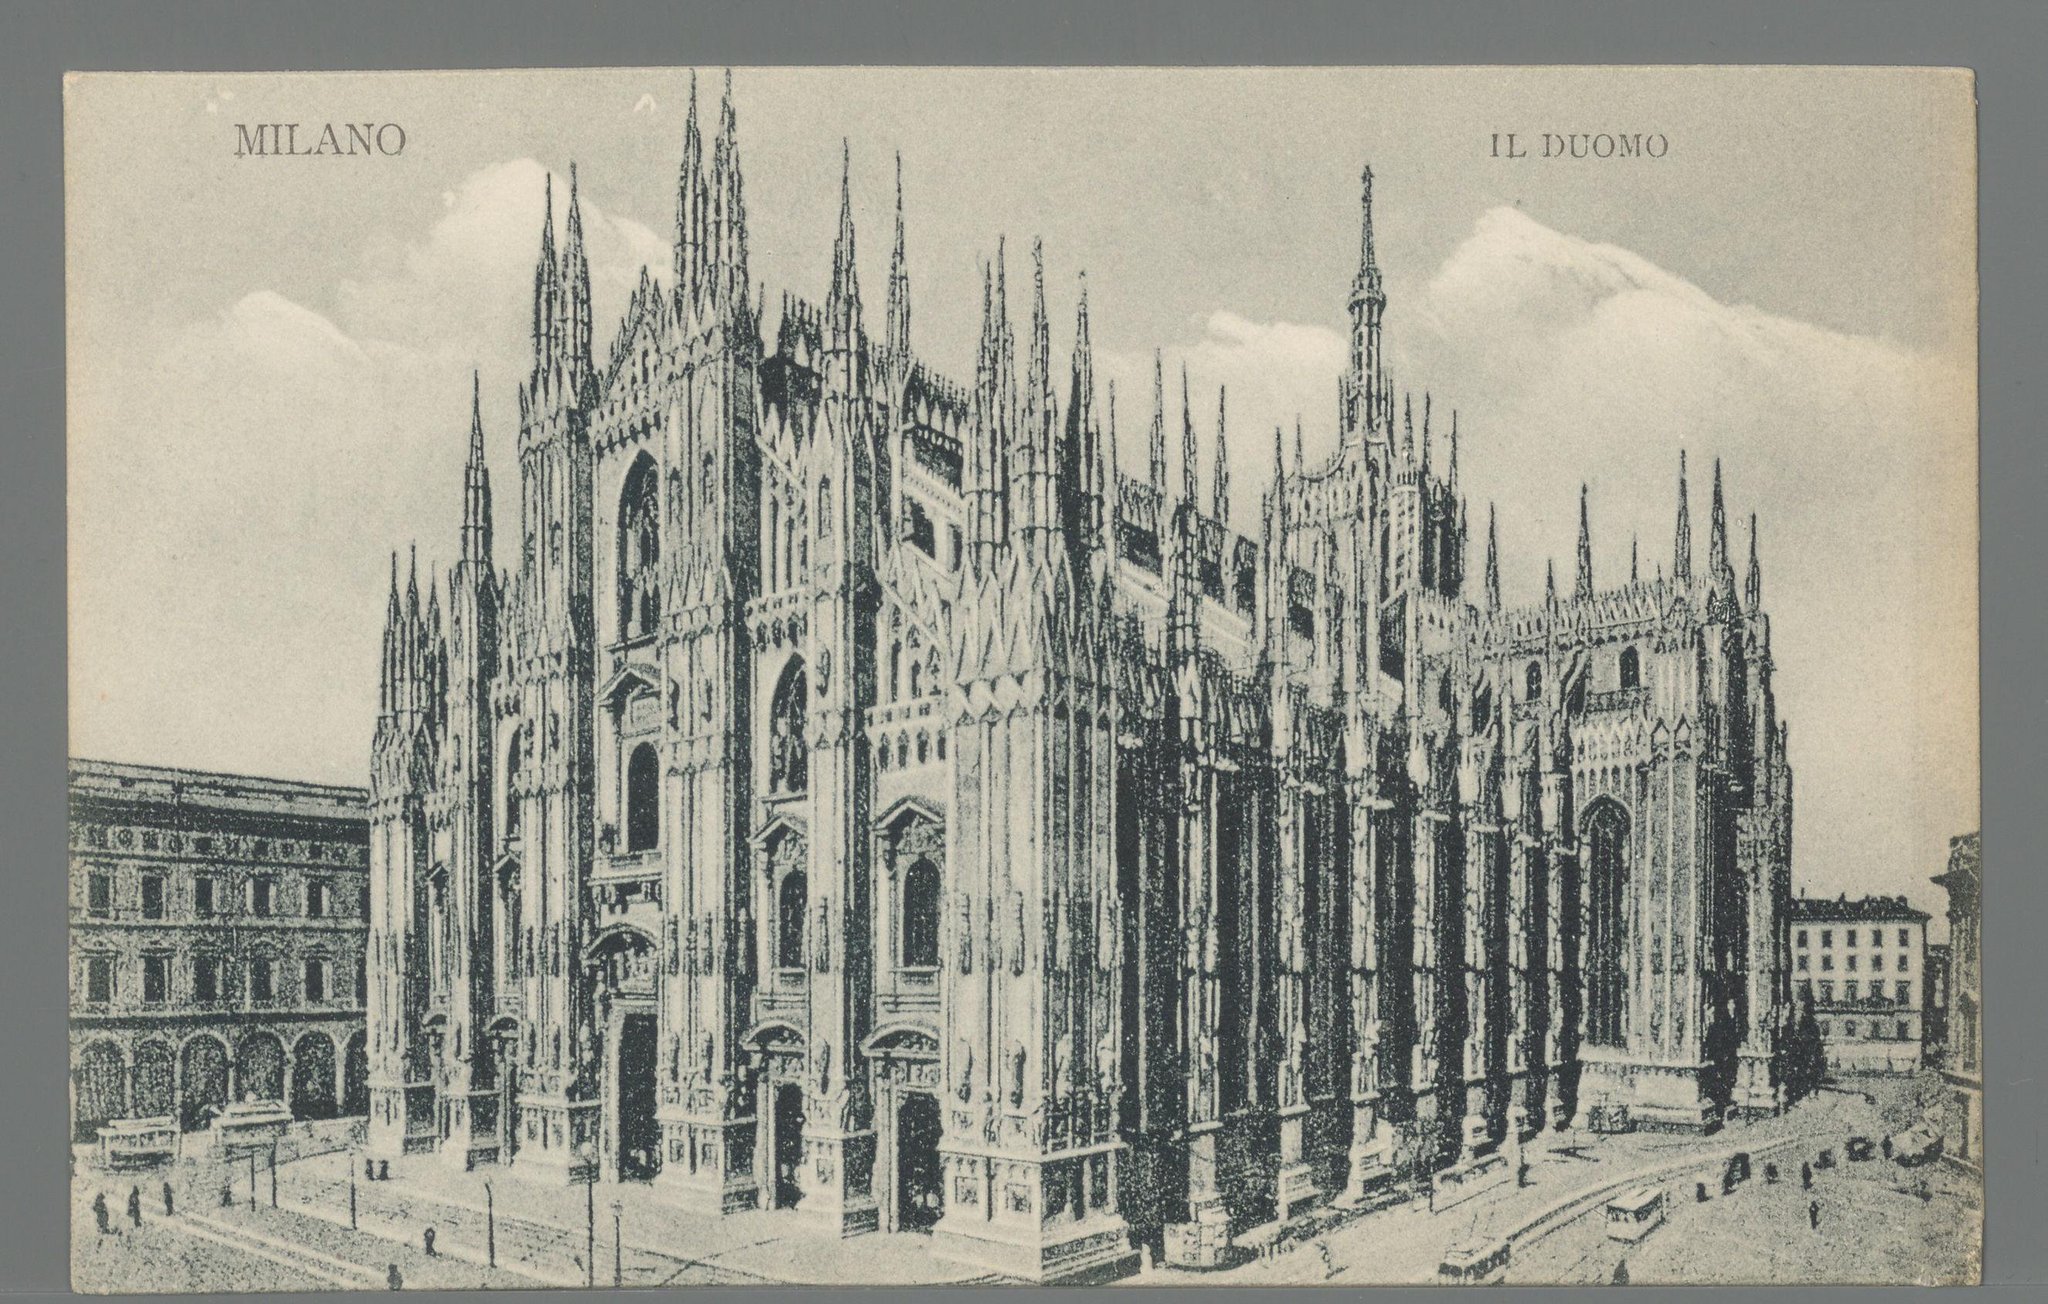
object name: photomechanical print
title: Milano. Il Duomo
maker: Anonymous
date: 1906-1920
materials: cardboard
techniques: photograph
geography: milan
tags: church (exterior), city-view, and landscape with man-made constructions (+ city(-scape) with figures, staffage)